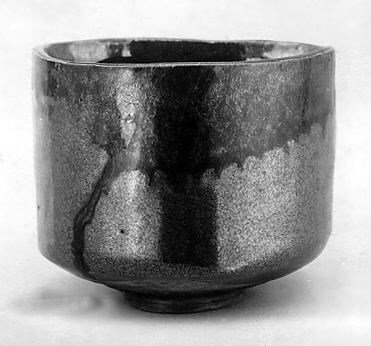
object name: teabowl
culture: japanese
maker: kiyomizu rokubei i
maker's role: artist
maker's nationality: japanese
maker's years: 1737-1799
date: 1701-1800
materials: clay, glaze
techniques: overglaze